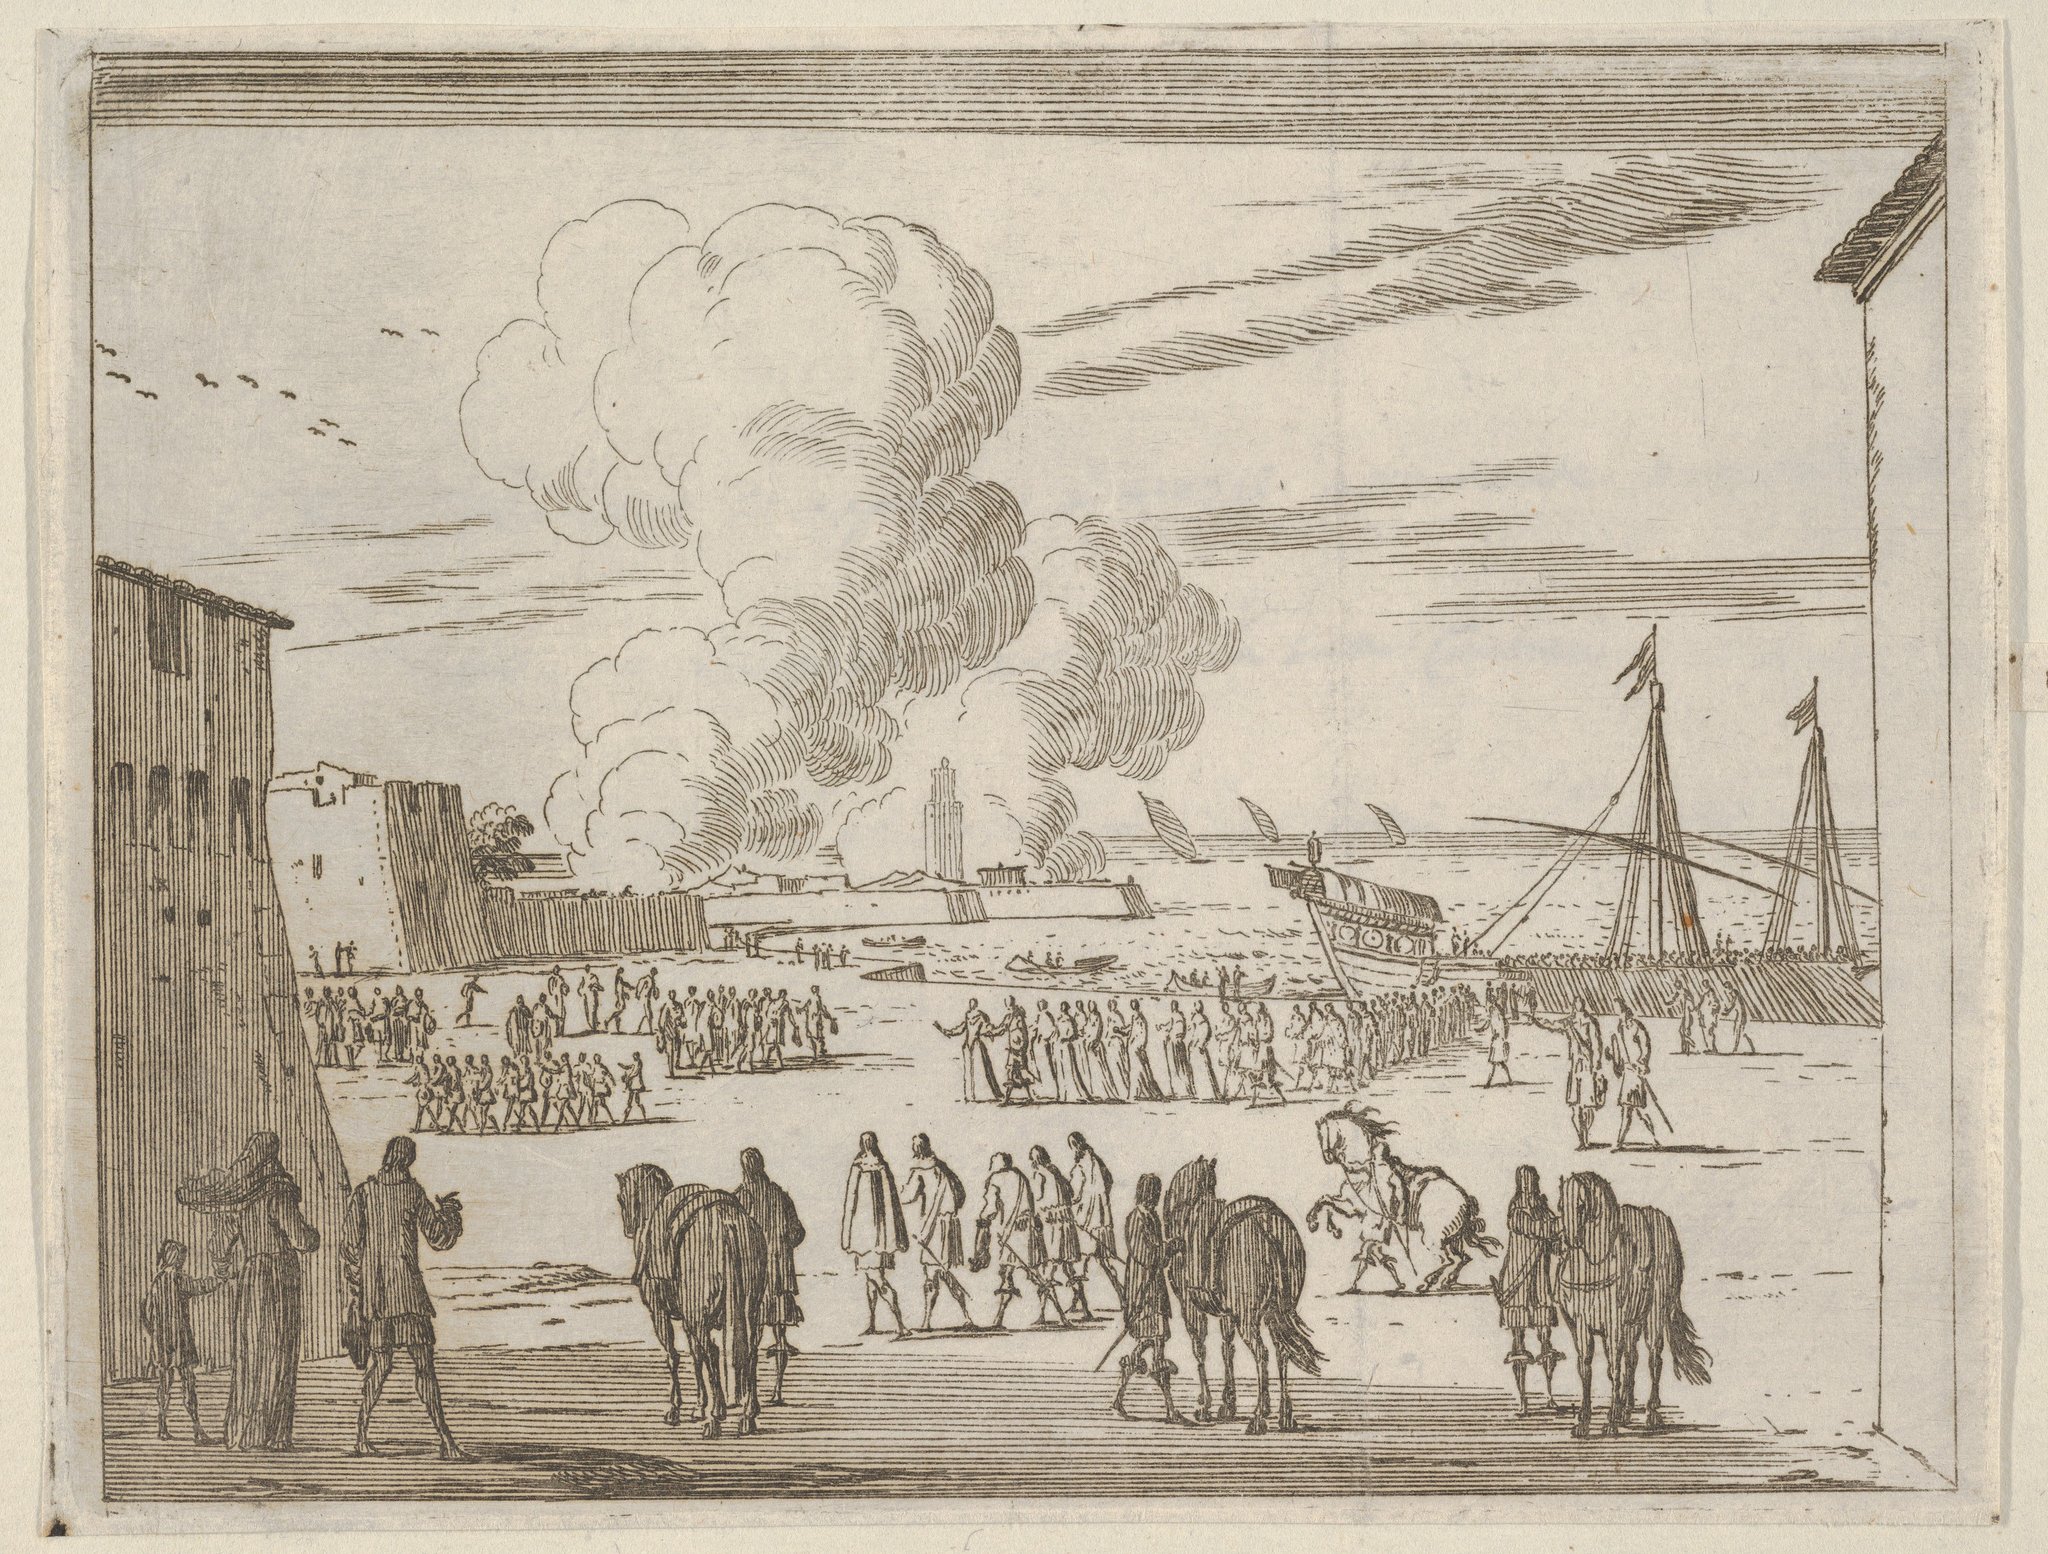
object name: print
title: Francesco I d'Este Makes an Effort to Save his Crown by Allying Himself with the Barberini Prince and an Unidentified Cardinal, from "L'Idea di un Principe ed Eroe Cristiano in Francesco I d'Este, di Modena e Reggio Duca VIII [...]"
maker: bartolomeo fenice (fénis)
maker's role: artist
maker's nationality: italian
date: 1659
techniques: etching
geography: italy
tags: men,horses